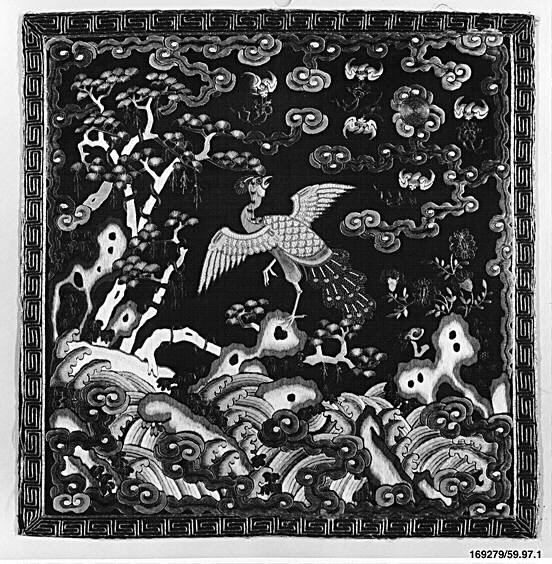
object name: rank badge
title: Rank Badge with Peacock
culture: chinese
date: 1767-1800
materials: metal thread, pearl, silk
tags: bats,peacocks